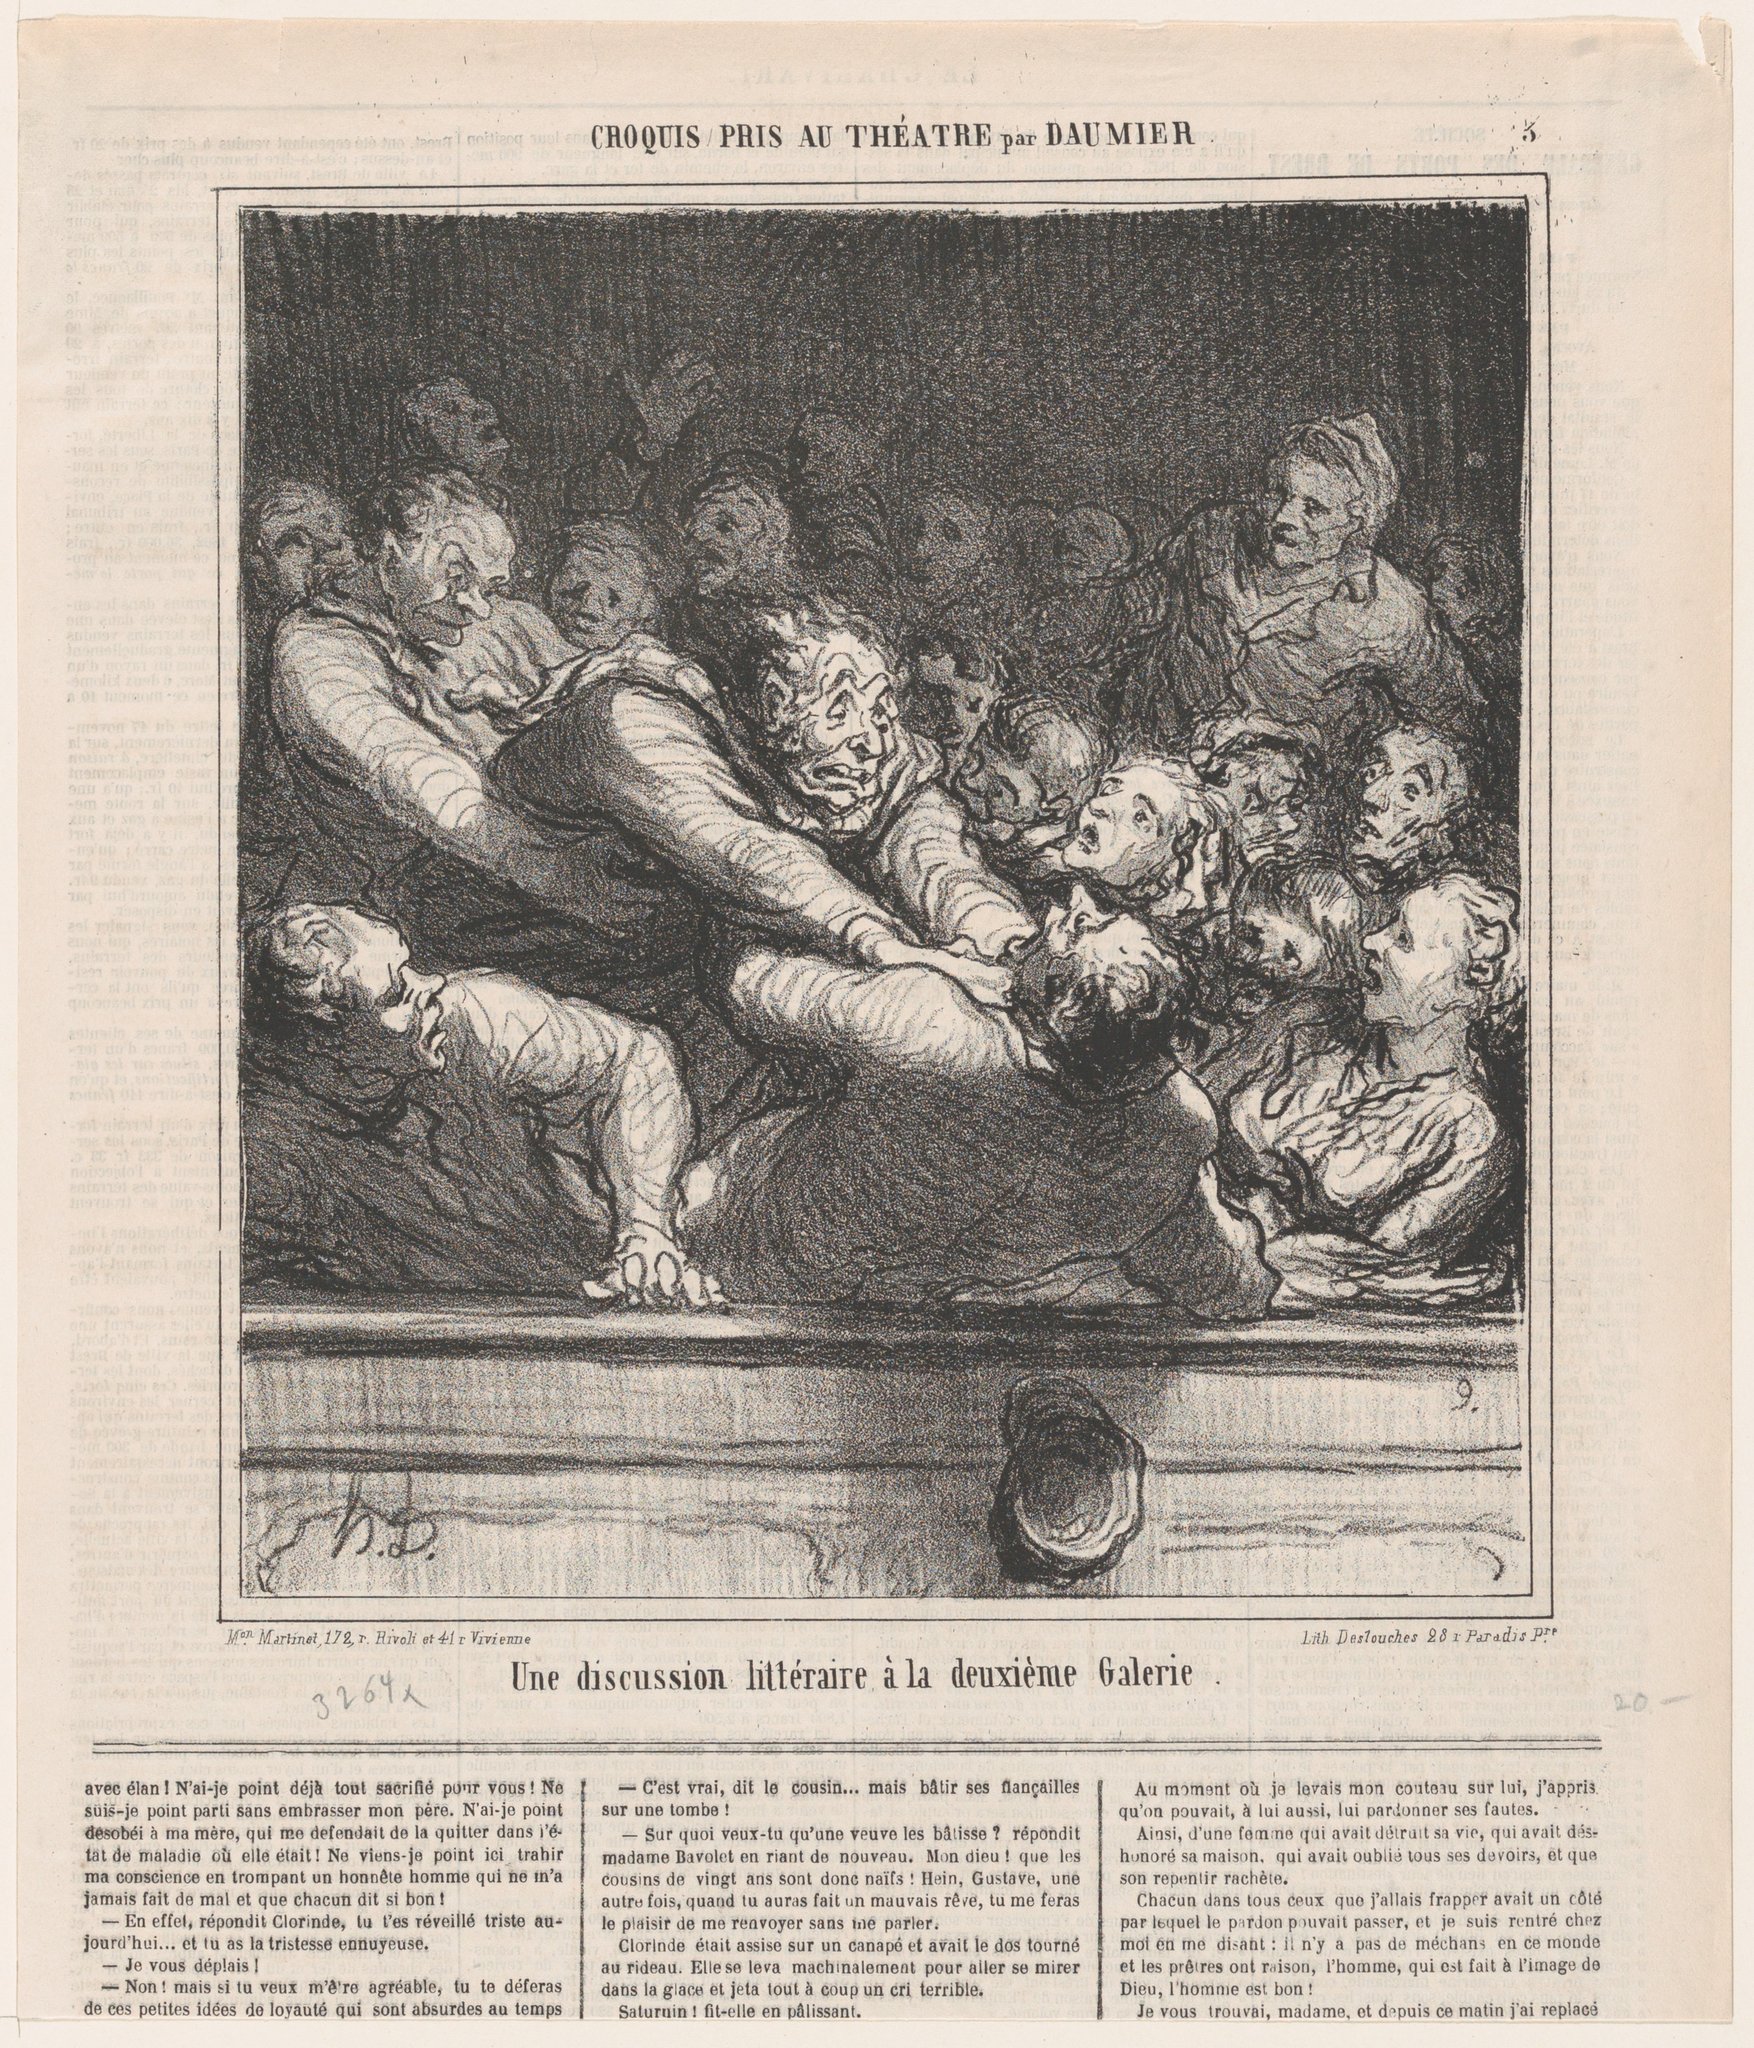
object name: print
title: A Literary Discussion in the Second Tier, from "Le Charivari"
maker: honoré daumier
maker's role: artist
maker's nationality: french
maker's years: 1808-1879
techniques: lithograph